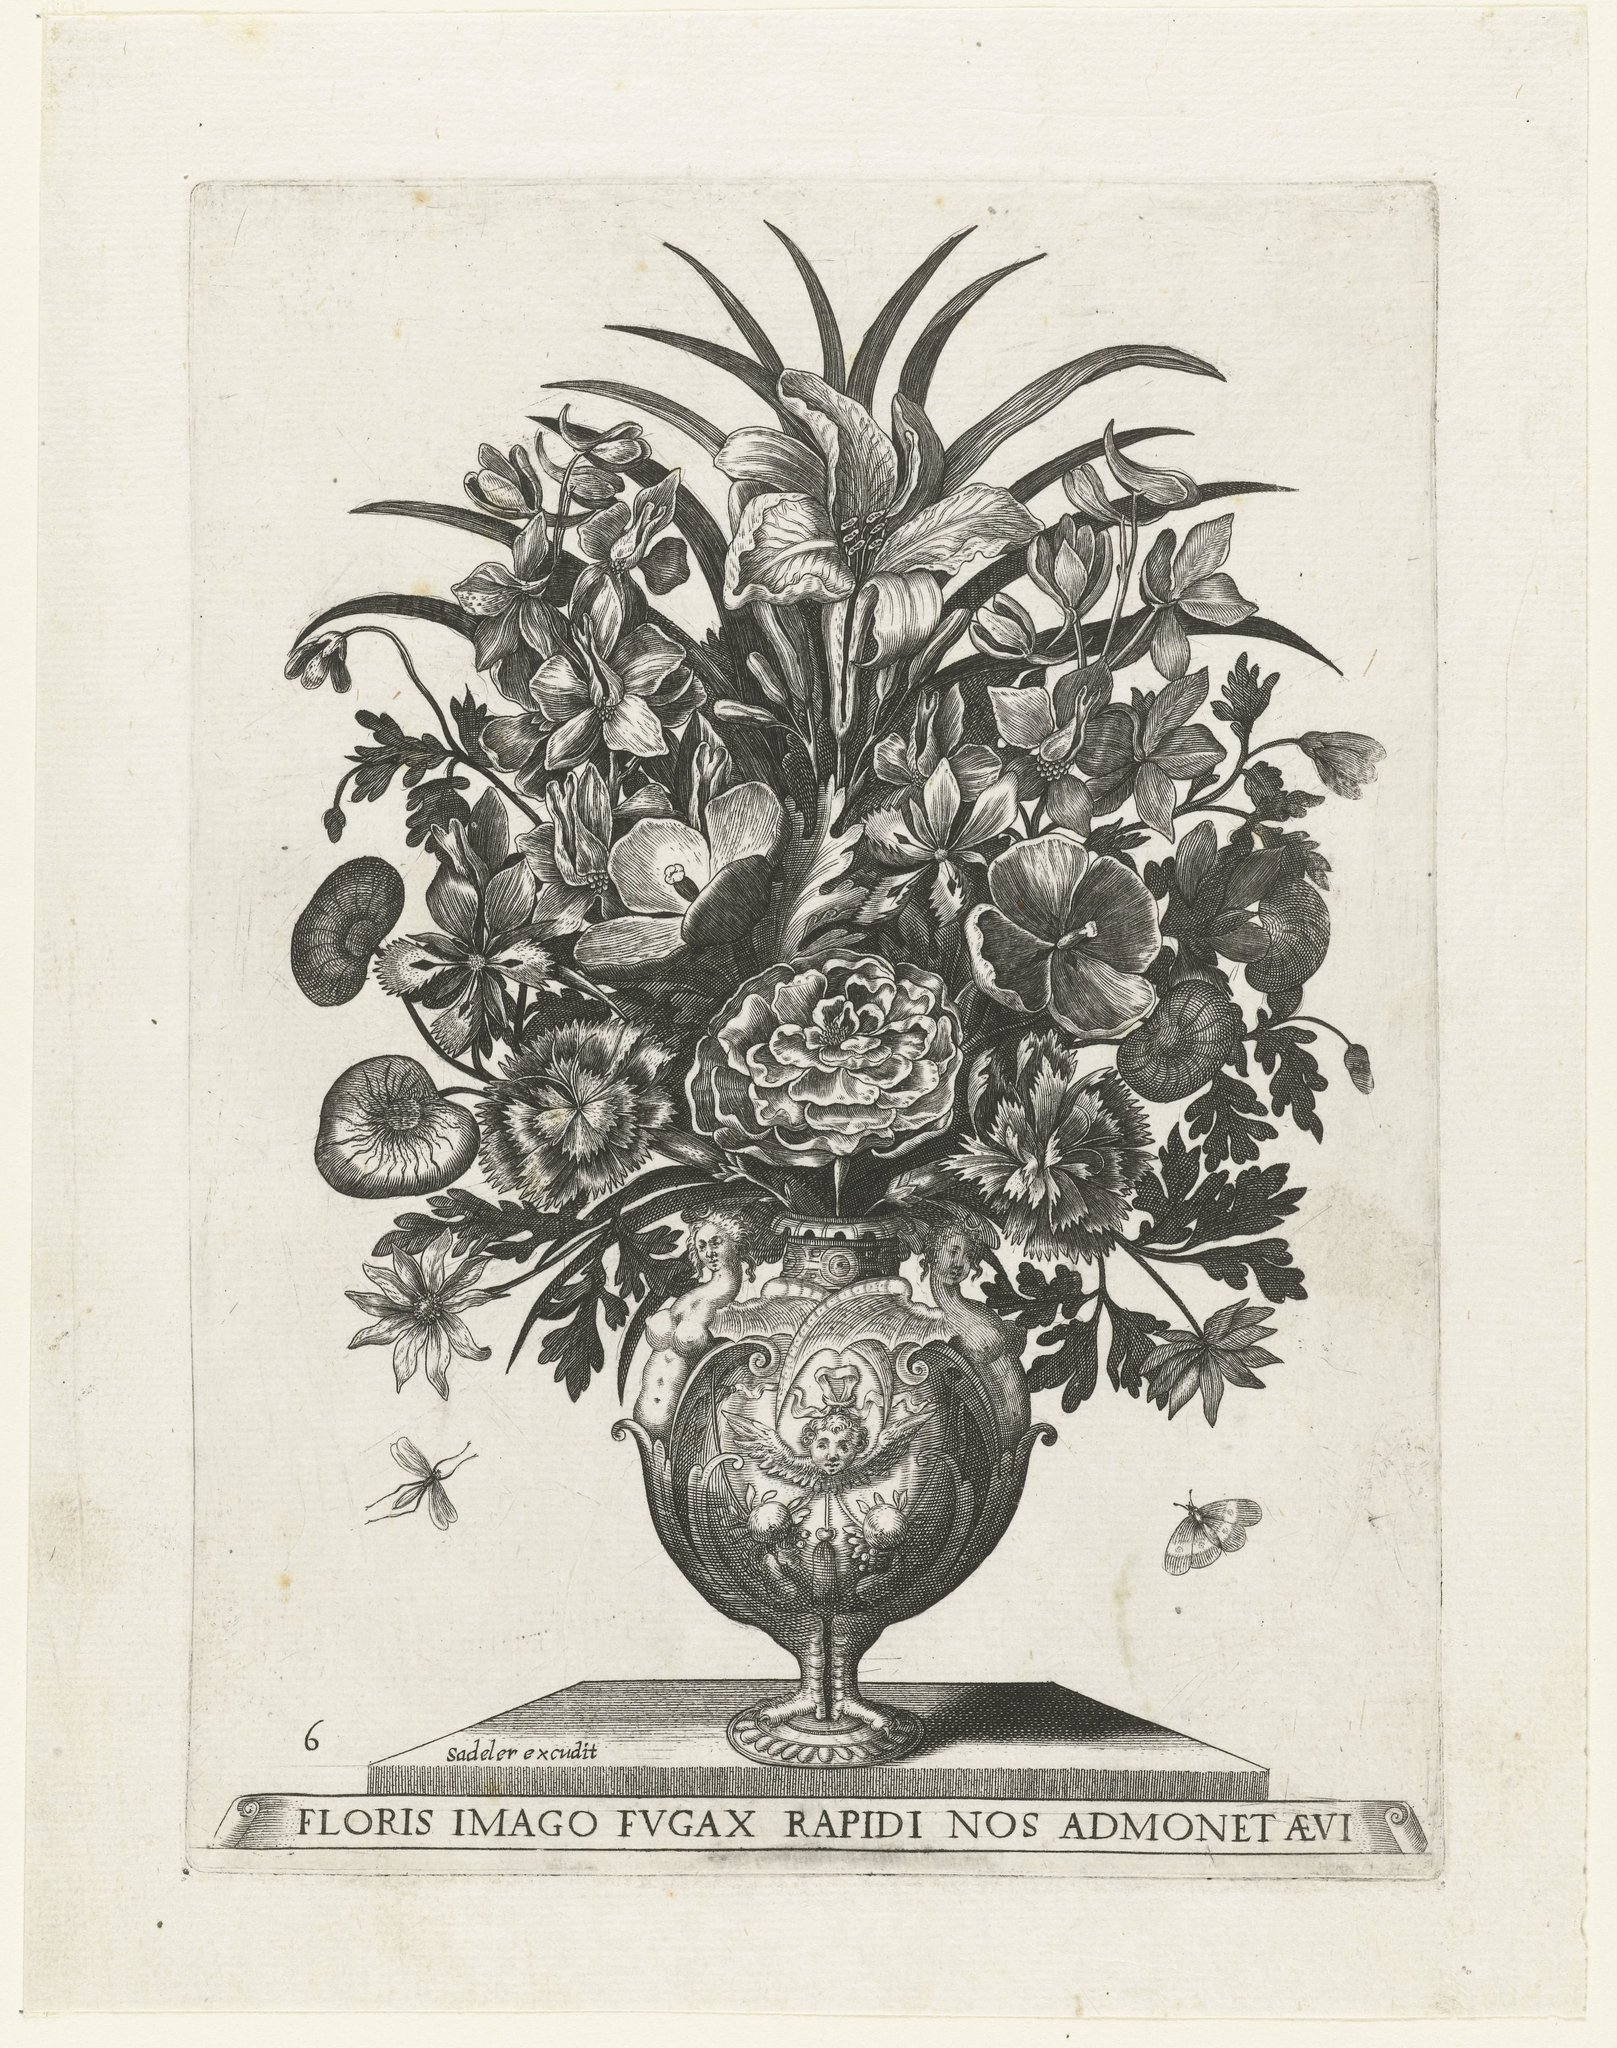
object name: print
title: Groteske vaas met een cherubijntje en guirlandes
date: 1500-1600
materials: paper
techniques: engraving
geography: germany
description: De oren worden gevormd door de bovenlichamen van twee gevleugelde vrouwen. In de vaas staan ondermeer anjers.